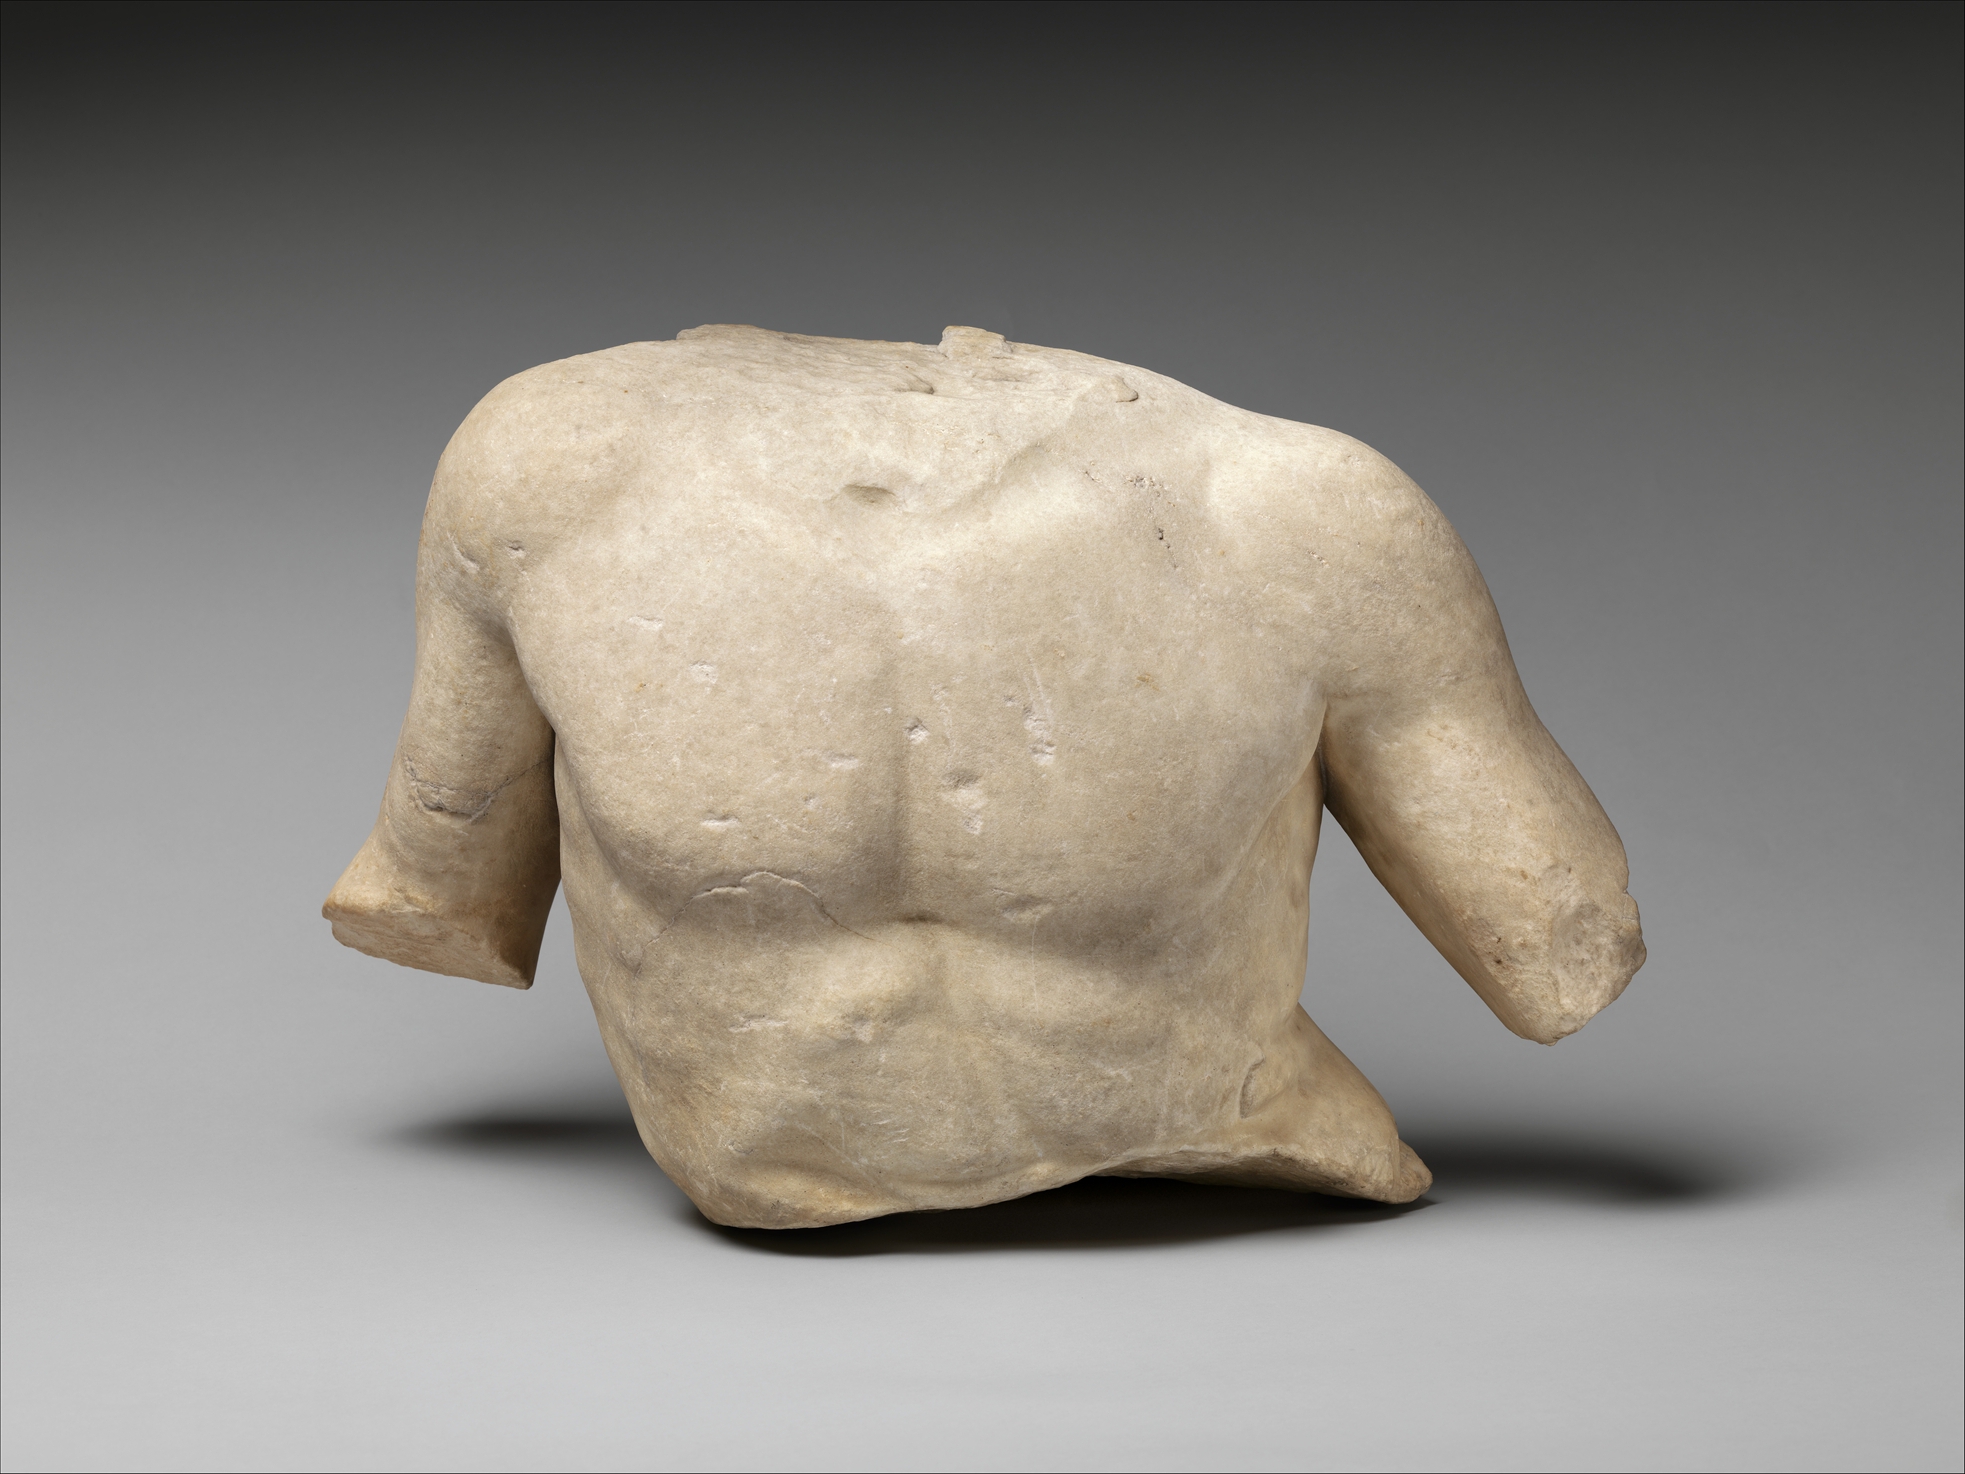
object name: torso of a man, fragmentary, from a pediment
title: Fragmentary marble torso of a man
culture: greek, attic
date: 450-400 BCE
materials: marble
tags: men